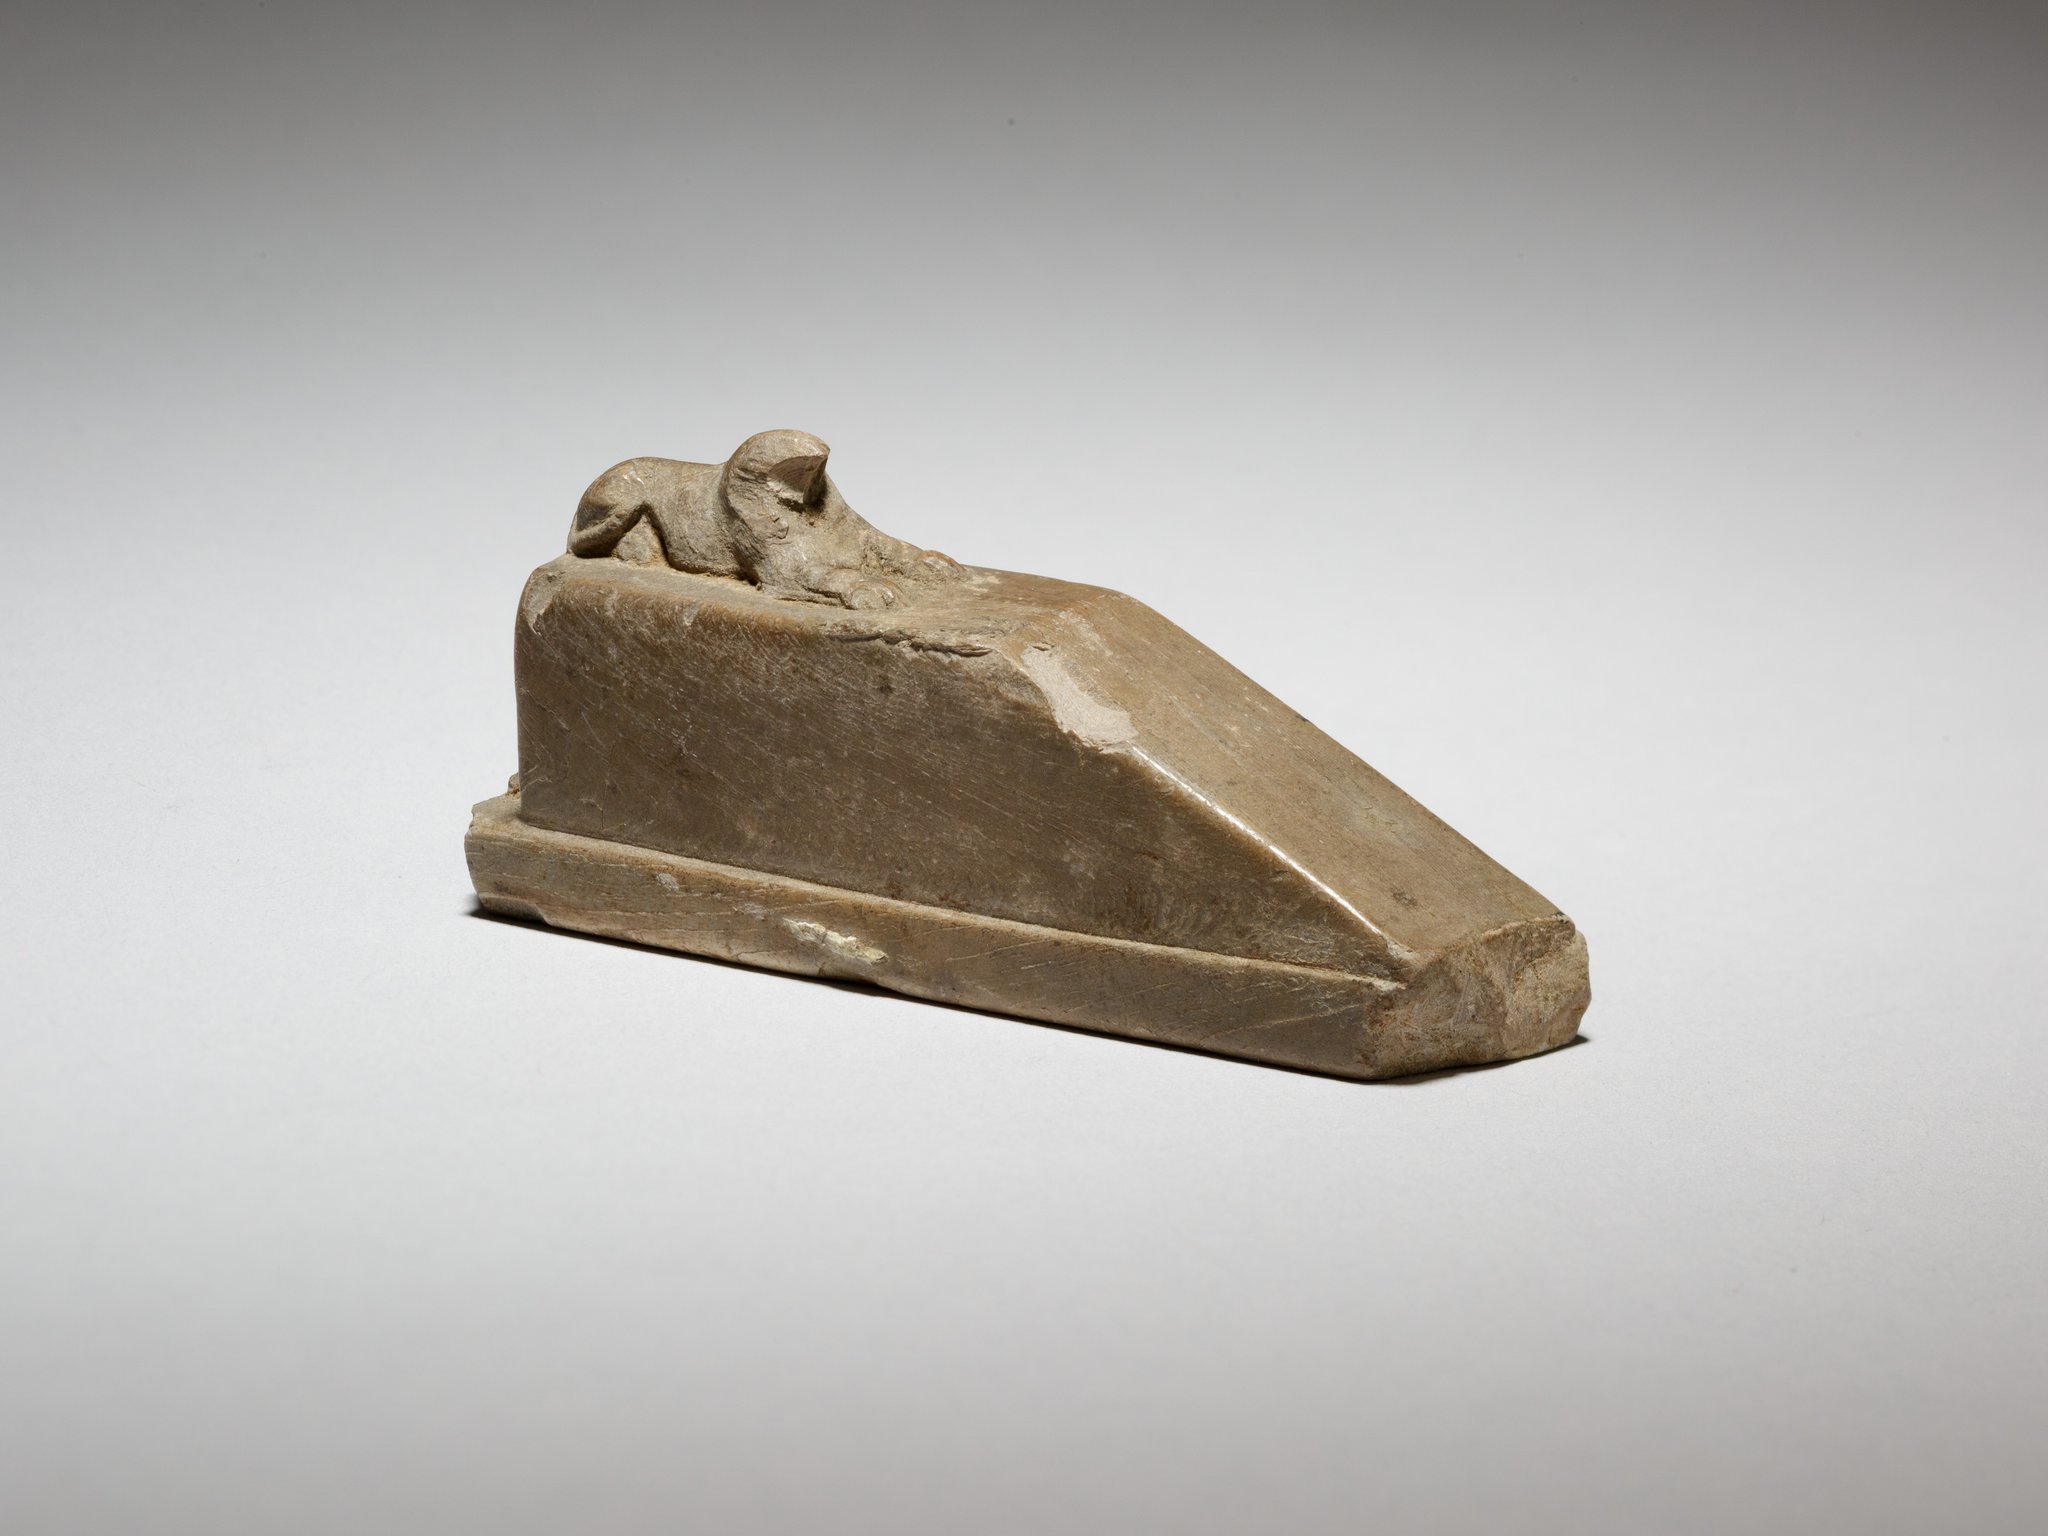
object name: amulet, sphinx, falcon headed, pedestal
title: Falcon-headed sphinx recumbent on a pedestal with a ramp, and a feline(?) behind, possibly a gnomon for a shadow clock or instrument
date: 664-630 BCE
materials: ivory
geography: egypt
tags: sphinx